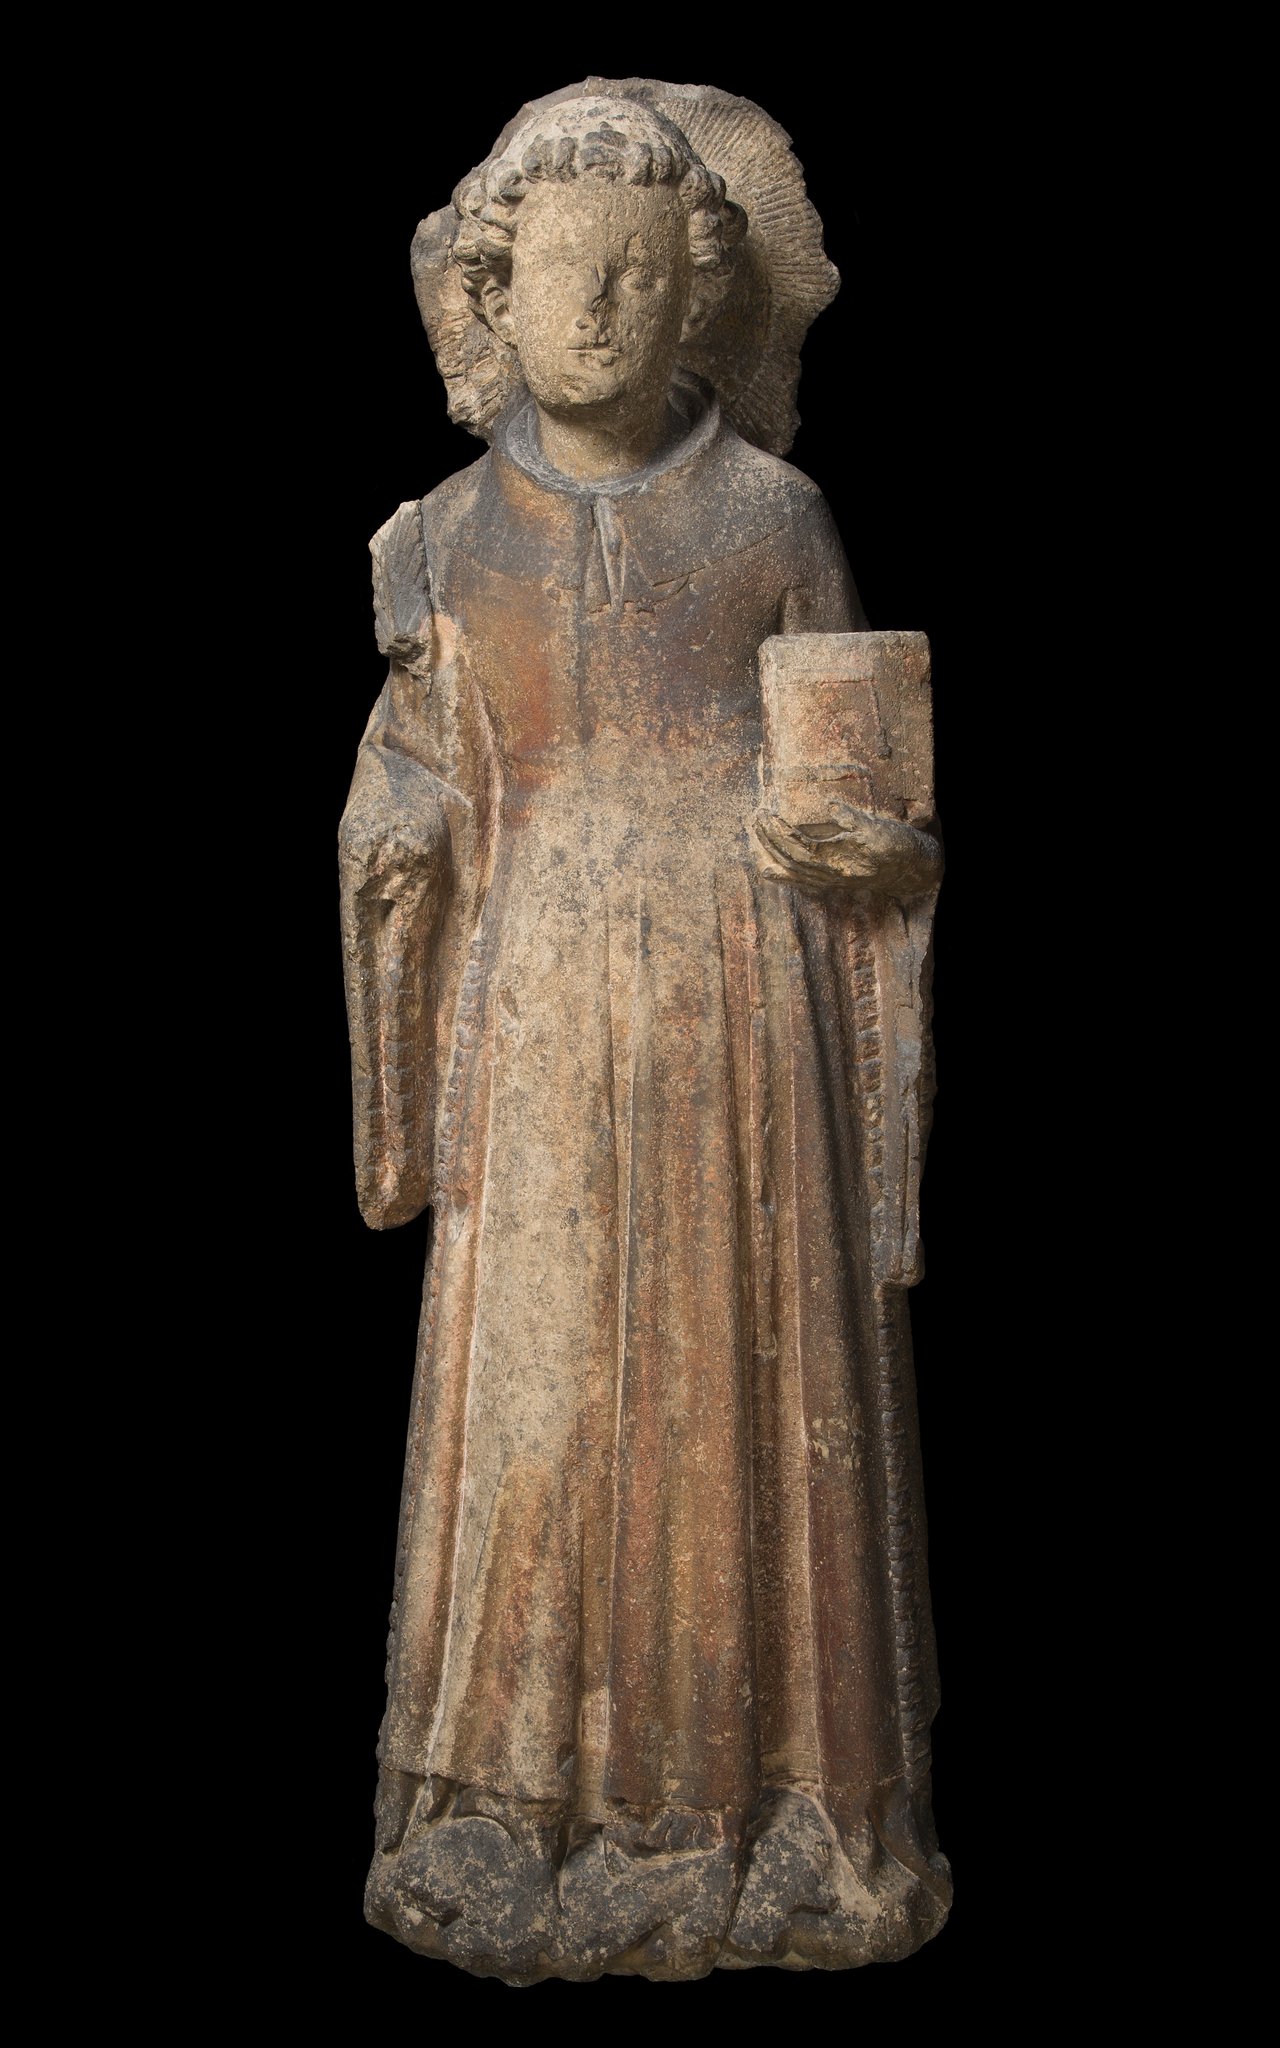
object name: statue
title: Martyred Deacon Saint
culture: french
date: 1325-1350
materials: limestone, paint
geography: france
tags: men,saints